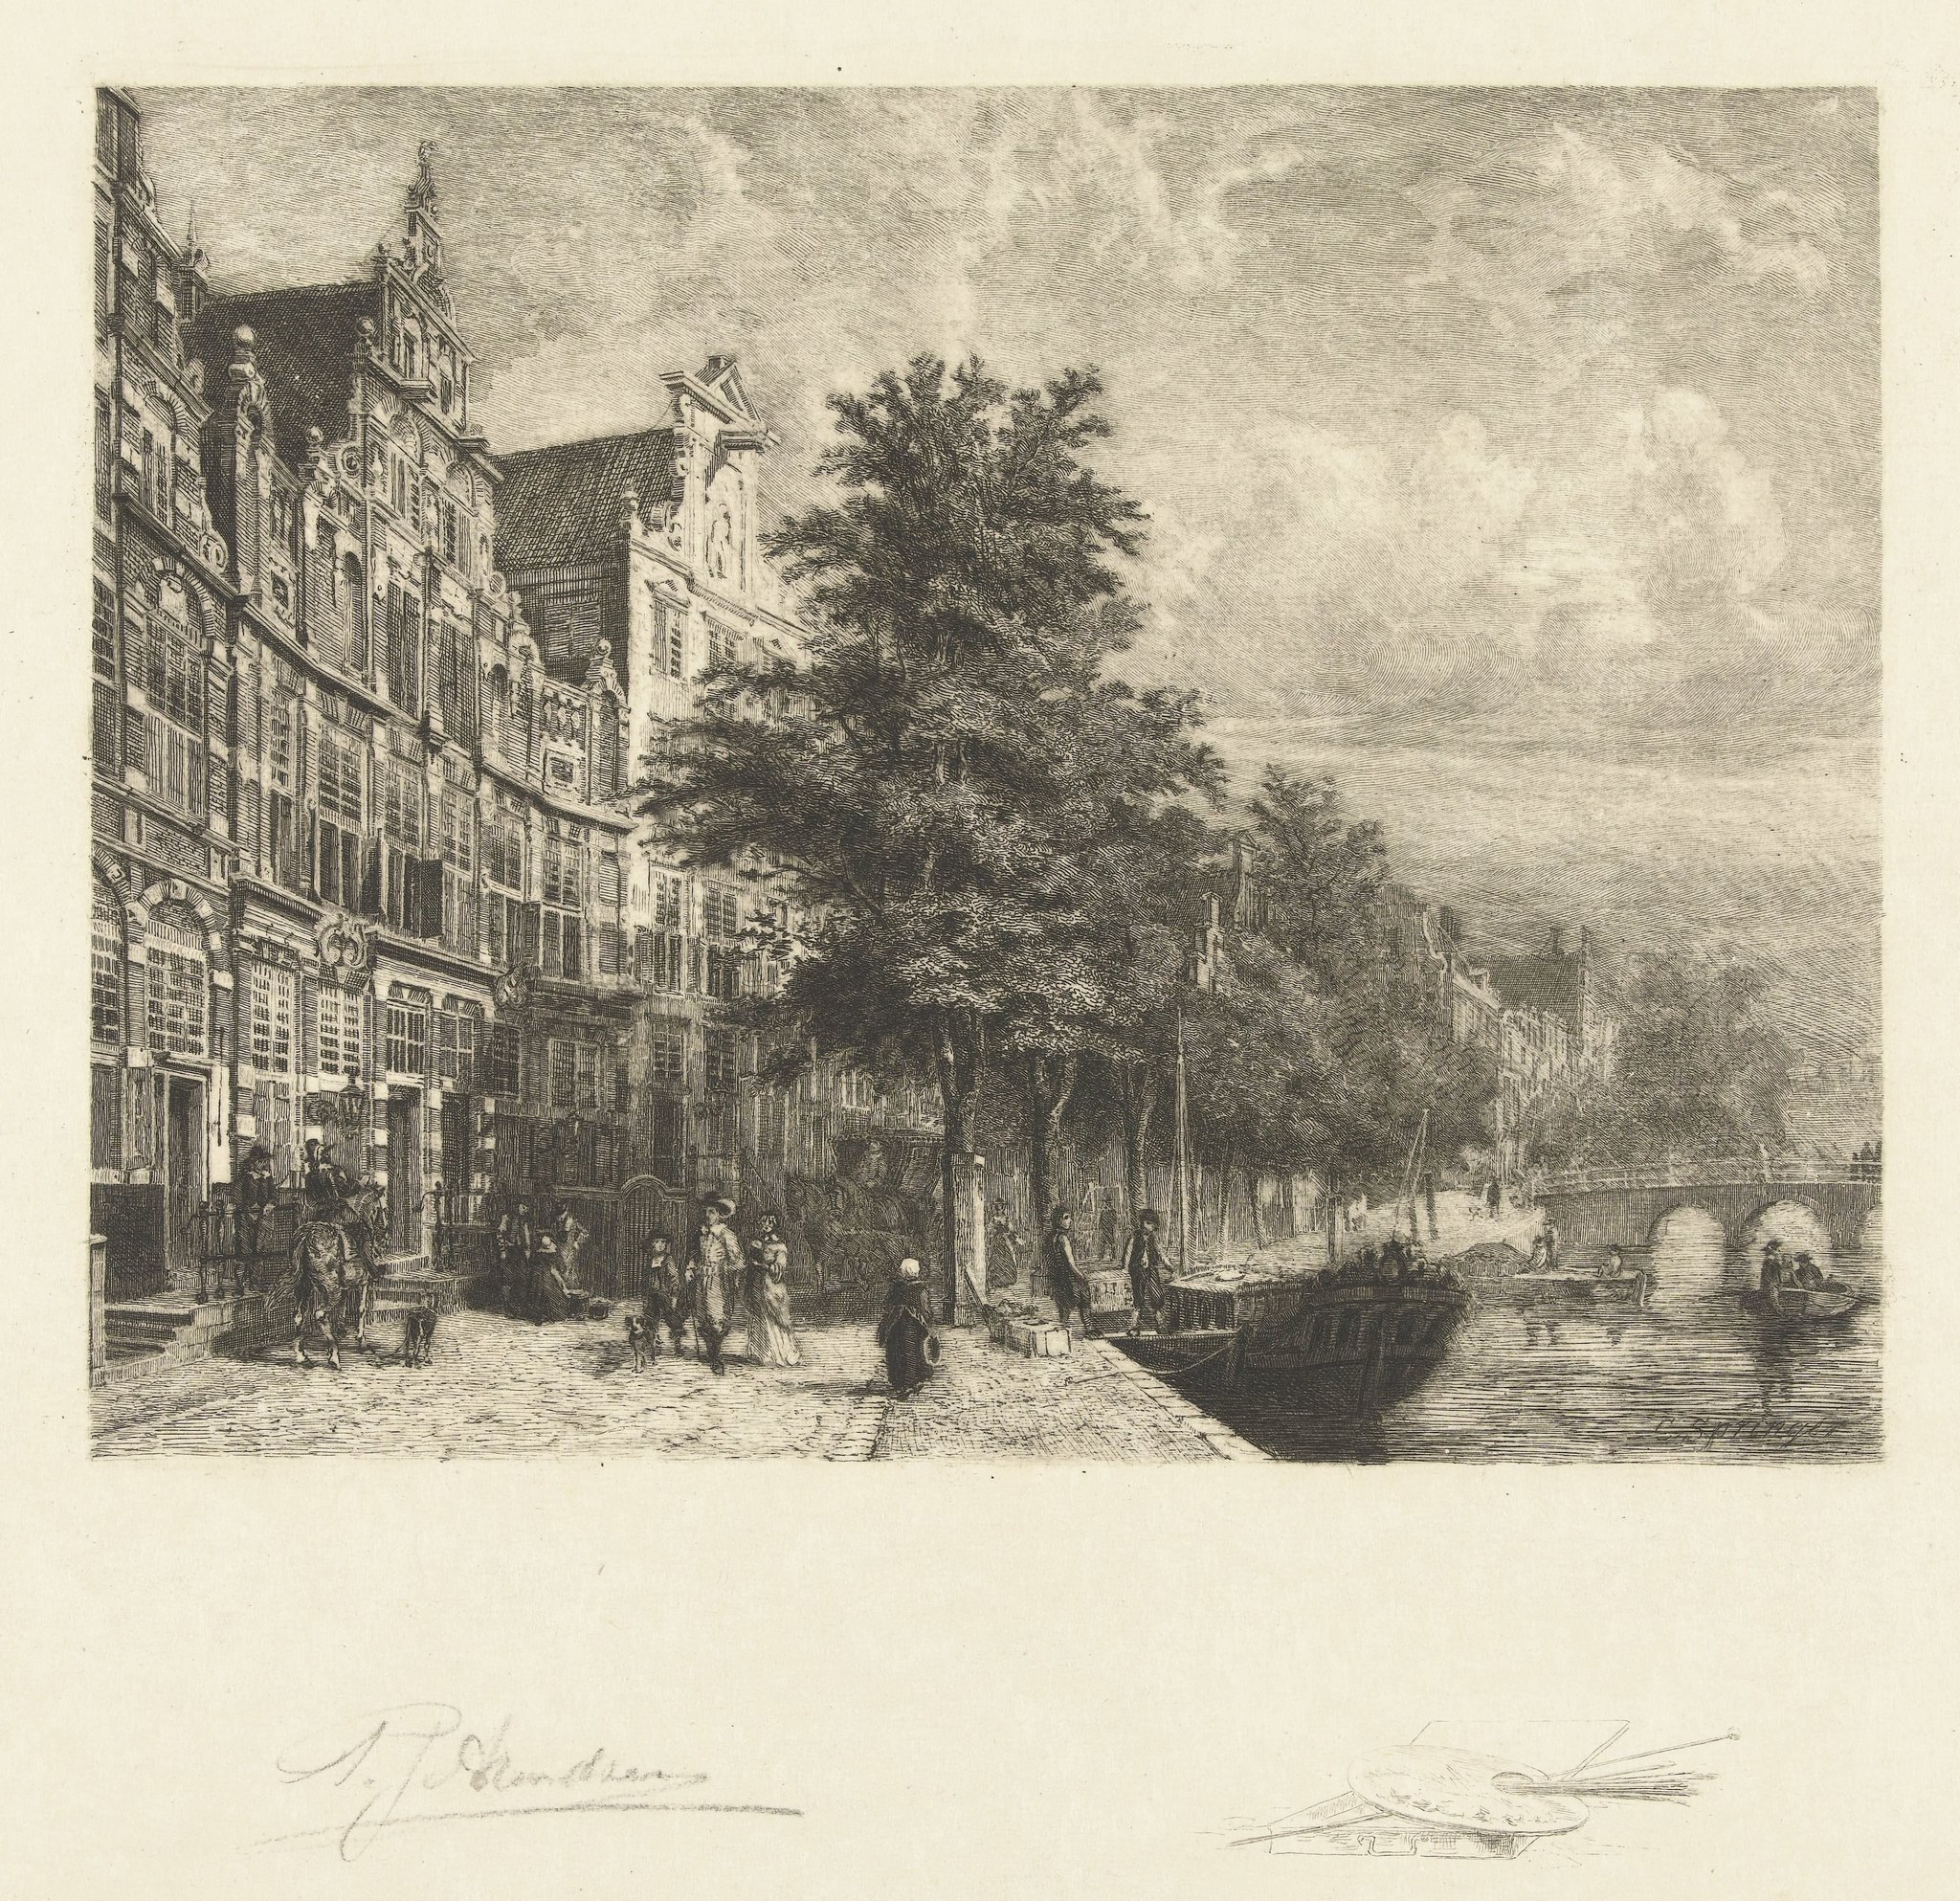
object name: print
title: Gezicht op de Herengracht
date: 1868-1900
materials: paper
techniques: etching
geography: netherlands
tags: canals, waters (in city)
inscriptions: collector's mark: Lugt 2228, collector's mark: Lugt 2760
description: Gezicht op de Herengracht in Amsterdam, met links het Huis Bartolotti. In marge een palet met penselen.